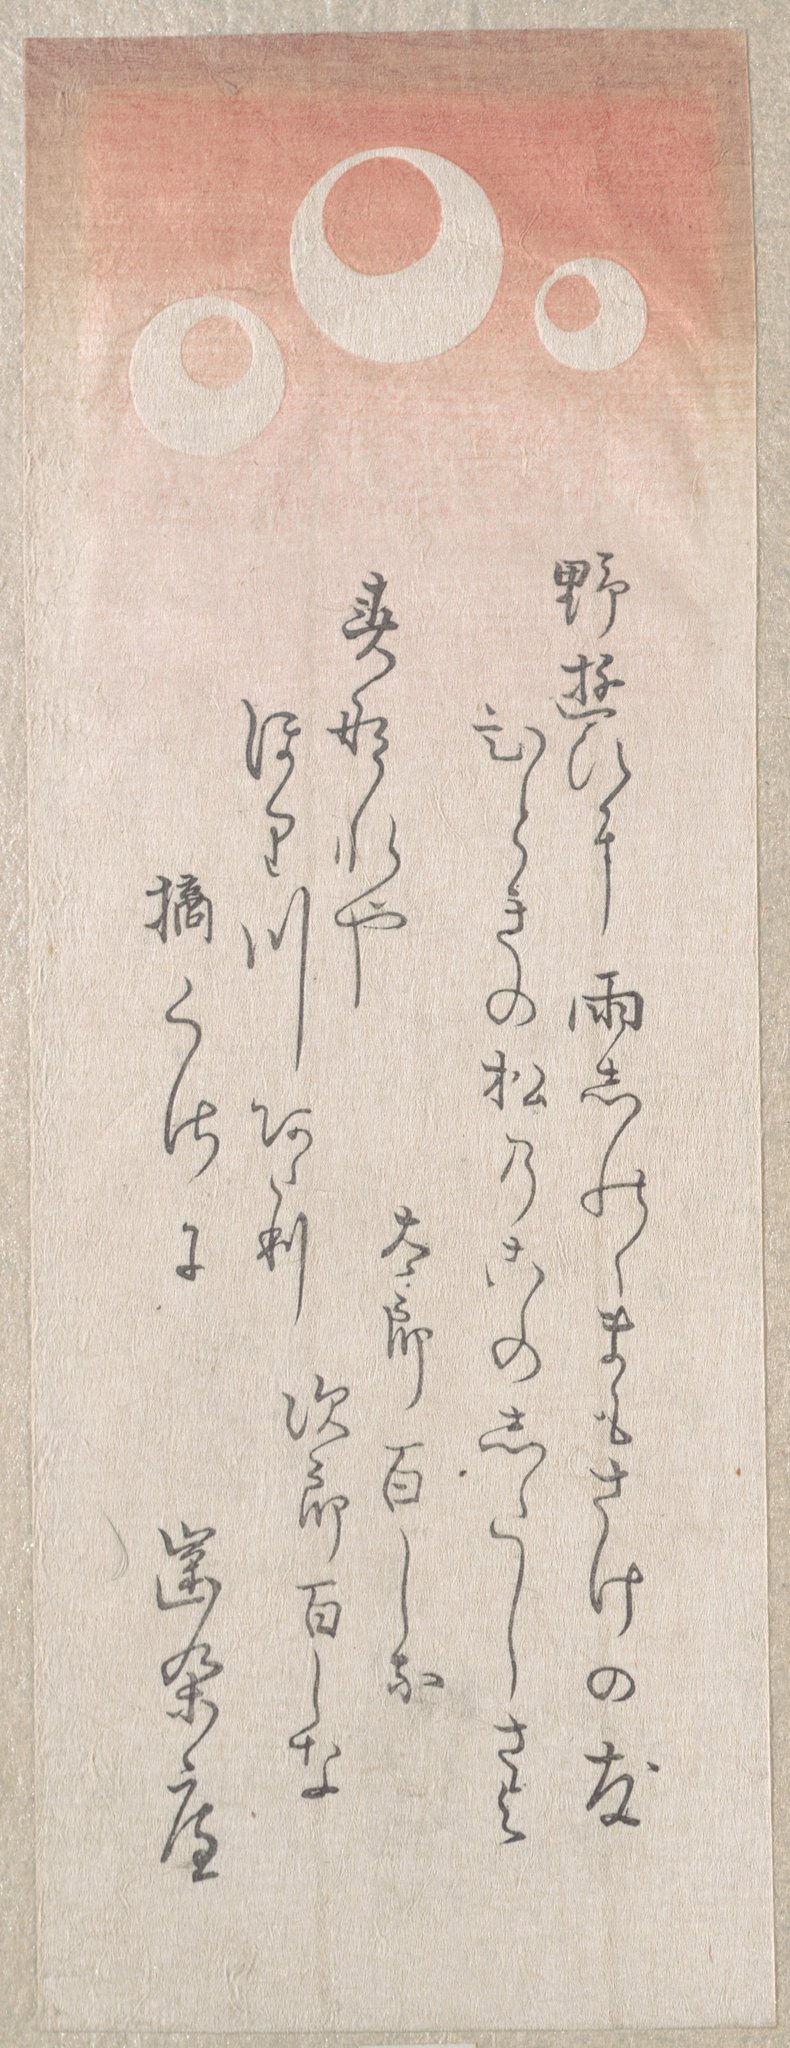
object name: print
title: New Year Card with Kyōka (Humerous Poem) and Three Disks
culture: japanese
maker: unidentified artist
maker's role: artist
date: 1701-1900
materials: ink, paper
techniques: surimono, woodblock print